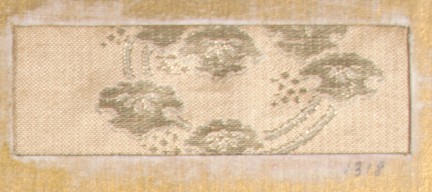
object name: piece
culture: japanese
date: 1701-1900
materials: silk